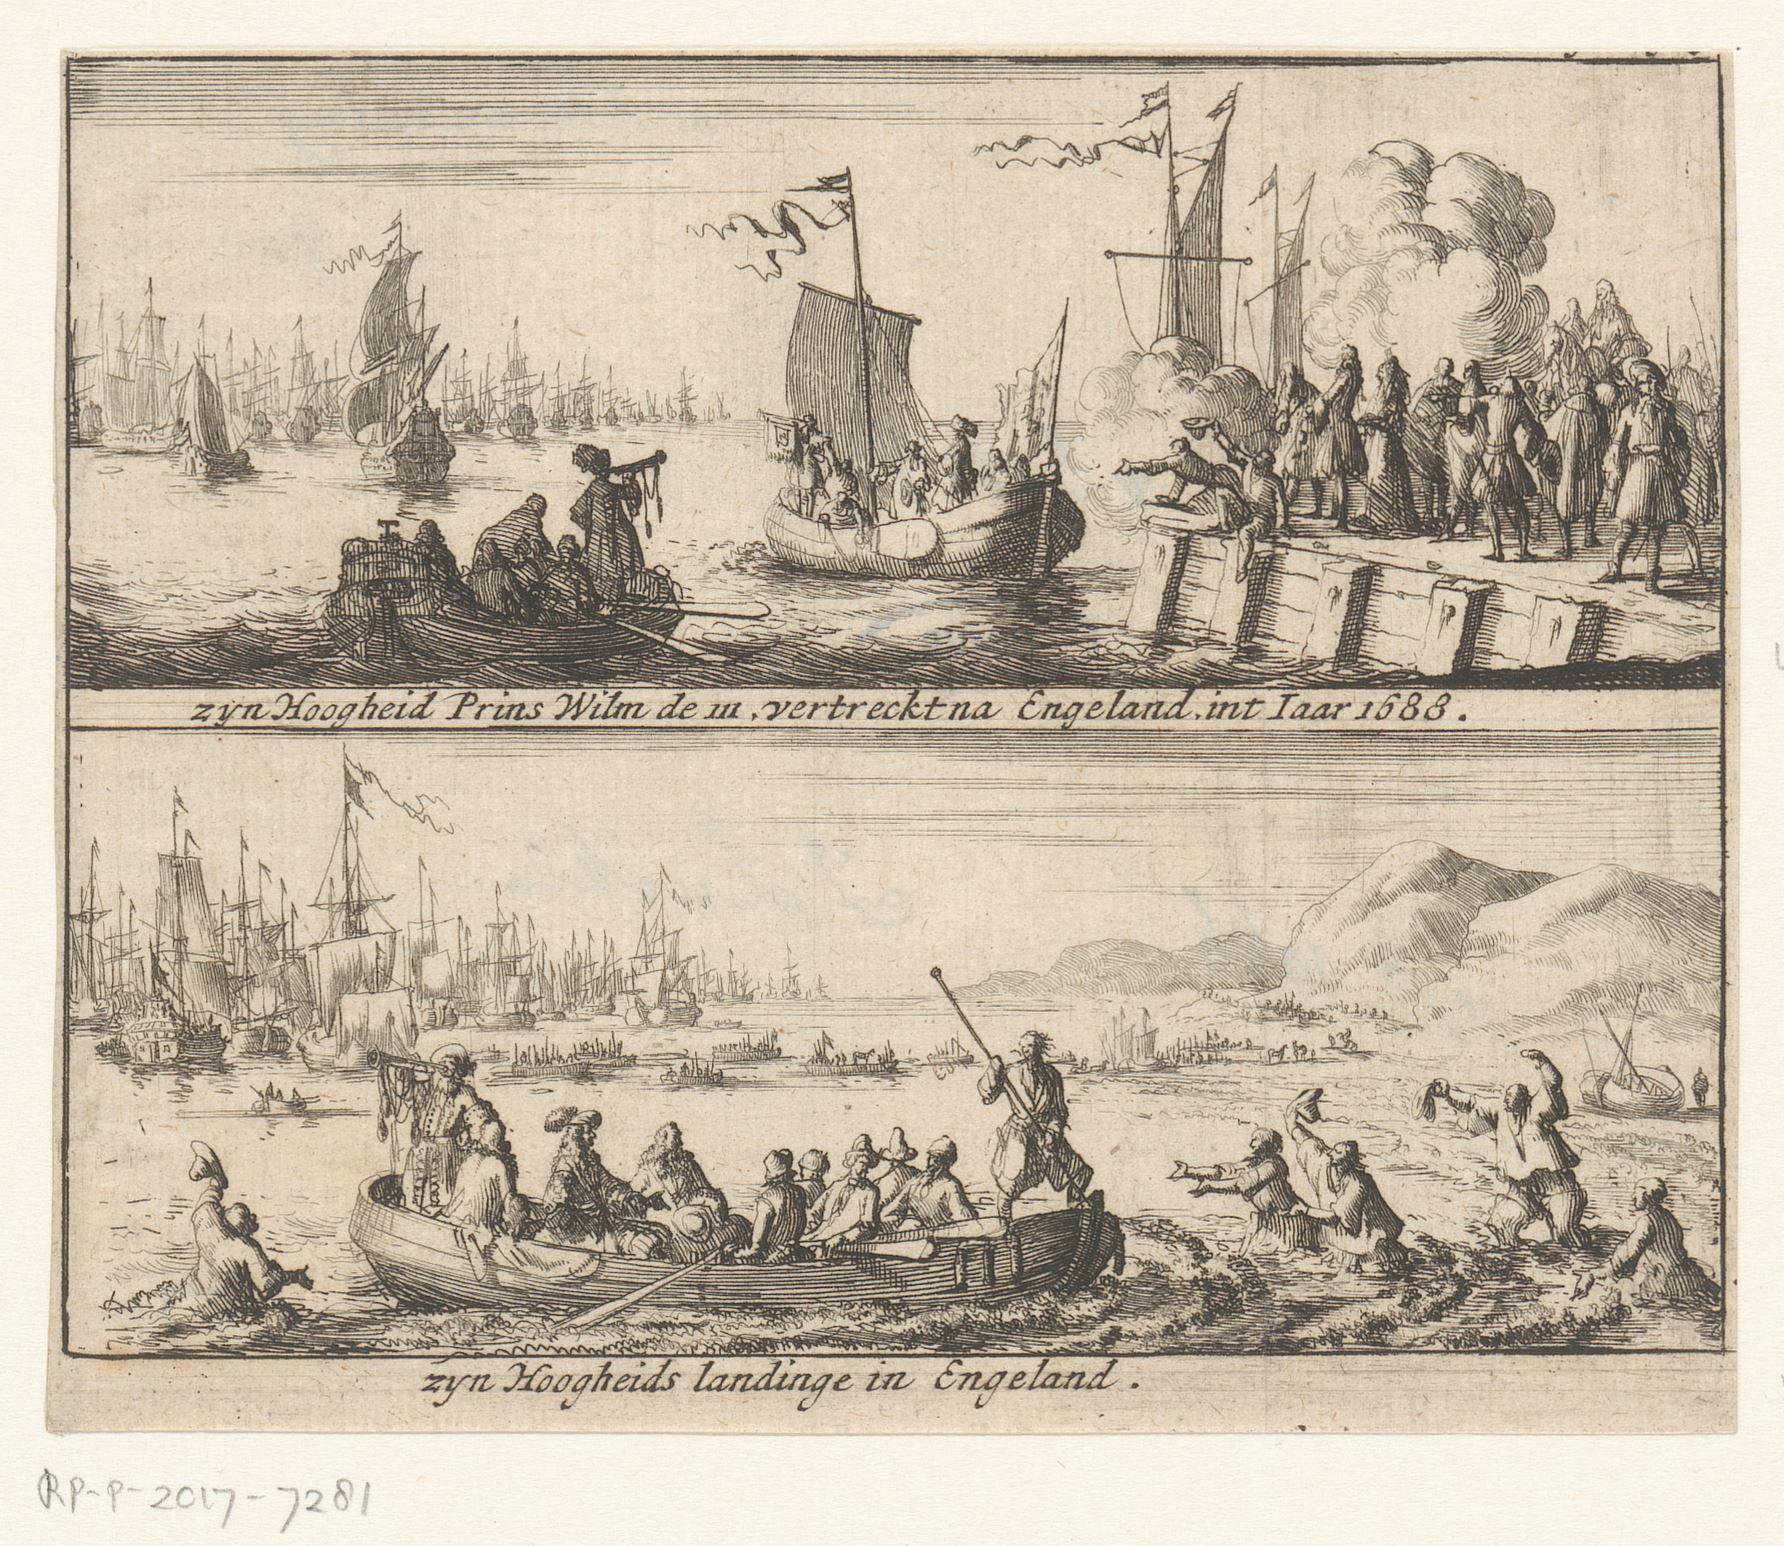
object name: book illustration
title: Vertrek naar en aankomst van prins Willem III in Engeland, 1688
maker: jan luyken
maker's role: draughtsman, print maker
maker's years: 1649-1712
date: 1689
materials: paper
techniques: etching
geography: northern netherlands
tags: william iii (prince of orange and king of england, scotland, and ireland), arrival and return ~ travelling, departure ~ travelling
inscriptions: collector's mark: Lugt 2228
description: Illustratie uit: Pers, Dirck Pietersz. Romeynschen adelaer, waer in de loffelĳcke en lasterlĳcke daden der Romeynsche koningen, en keyseren, verhandelt werden, 3 delen. Utrecht: Jurriaen van Poolsum, 1689, fol. 897. Deze prent is ook genummerd FMH 2696 als illustratie voor: Lambert van den Bosch, Het leven en bedryf van Willem de Darde, Jan Claesz ten Hoorn, Amsterdam 1694, 4 delen.